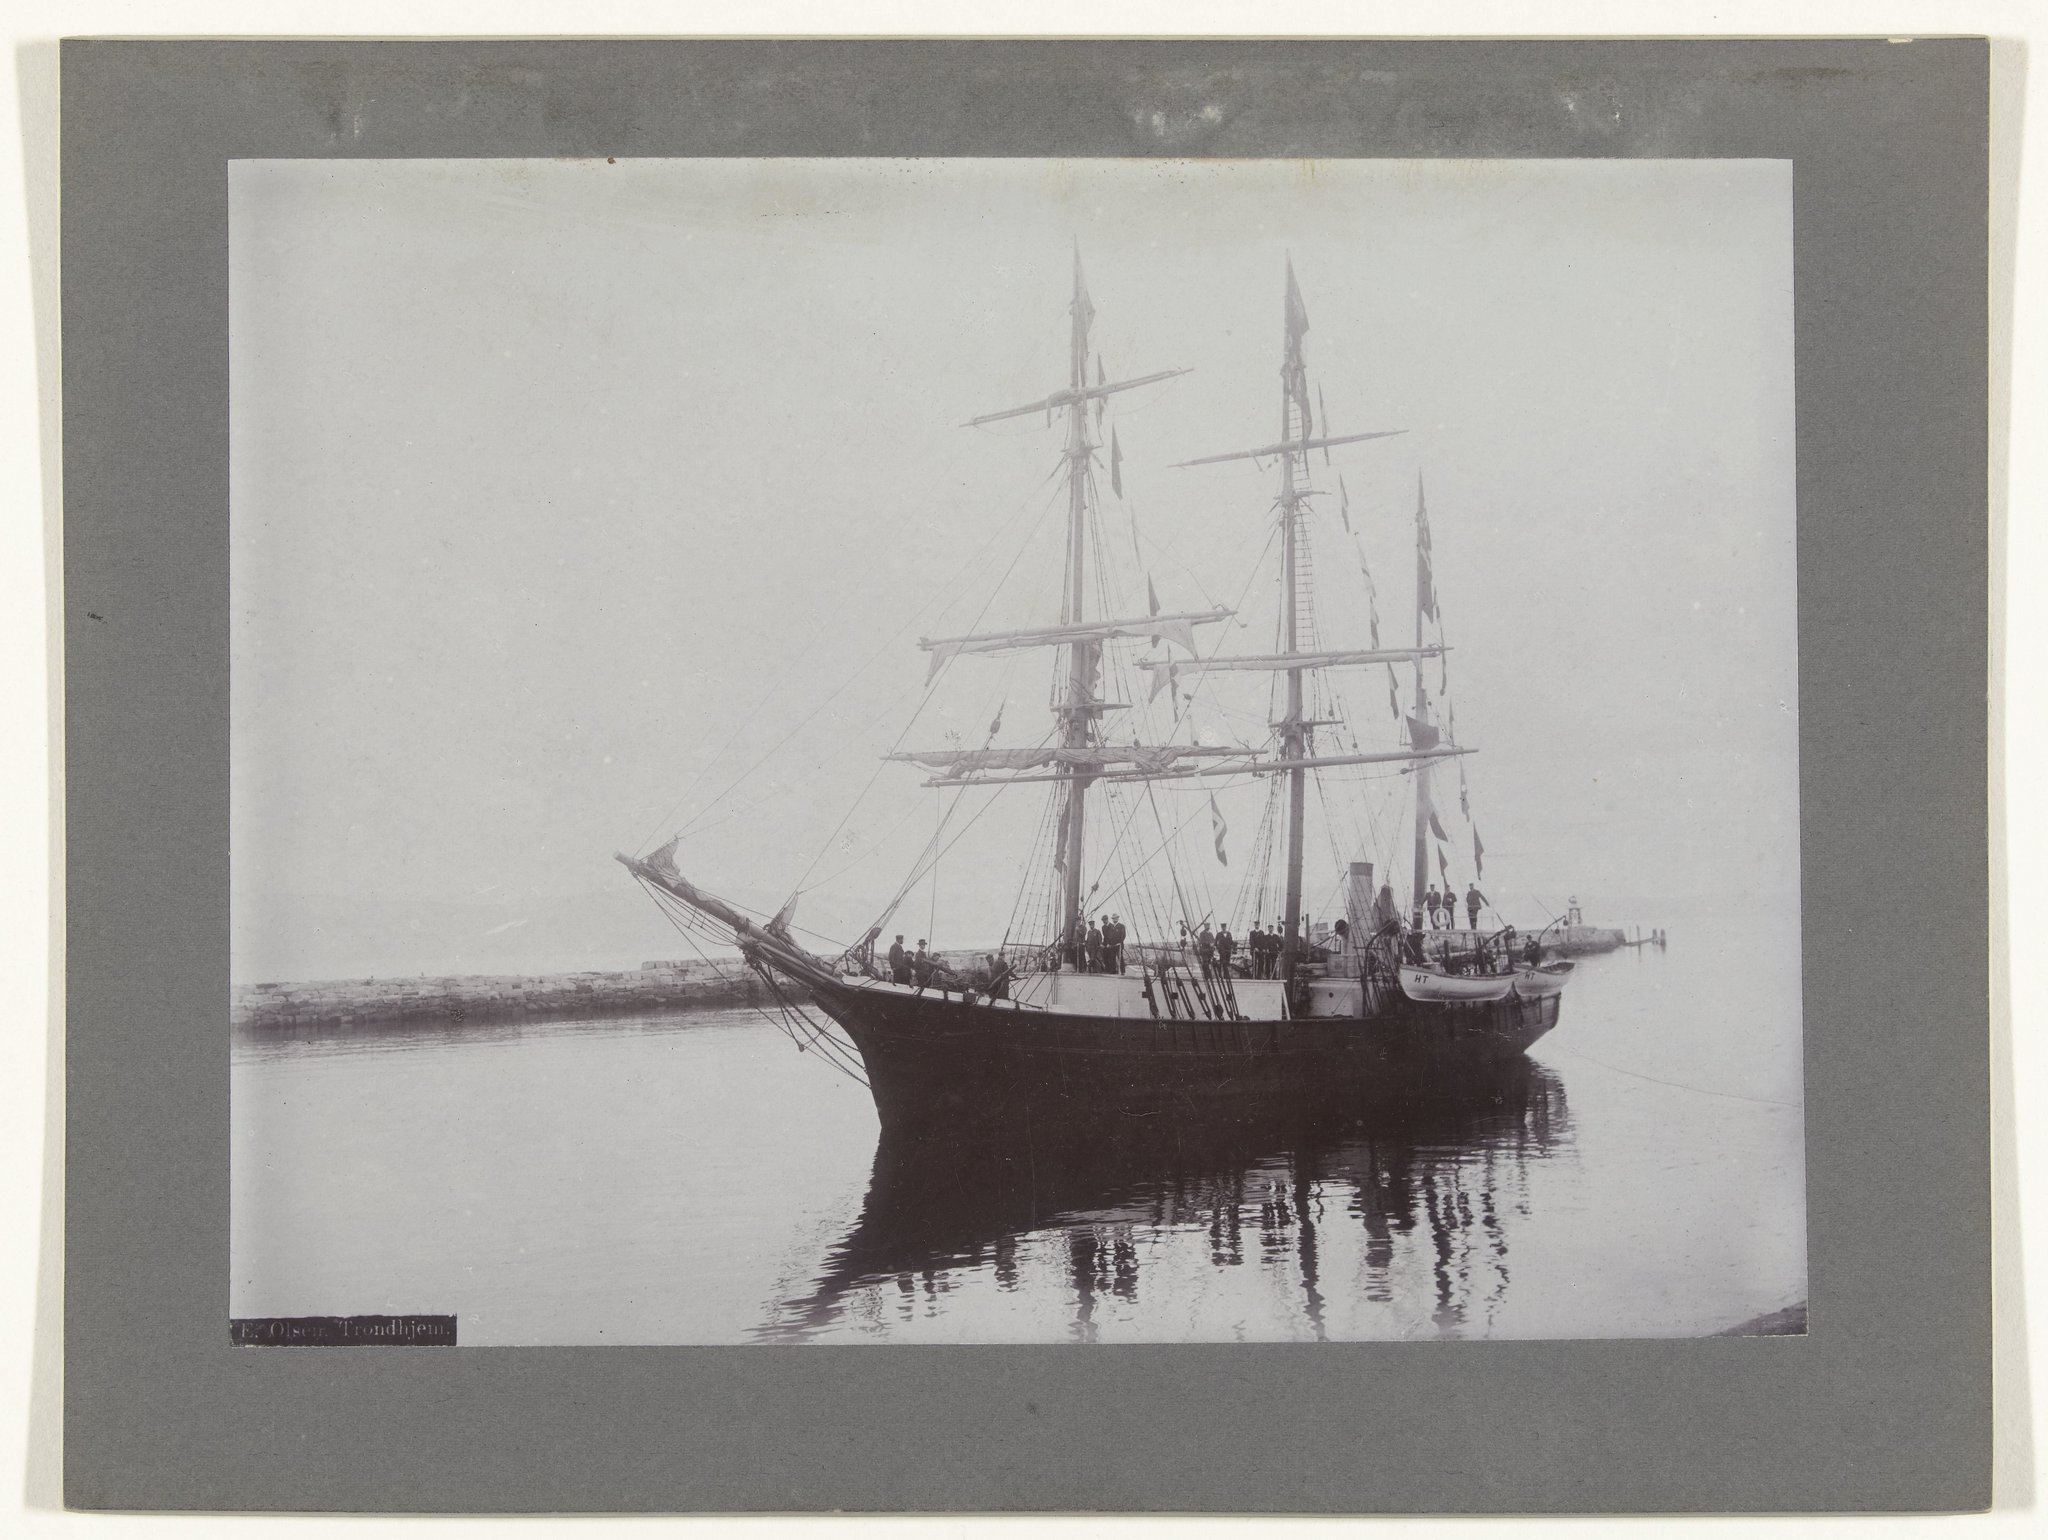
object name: photograph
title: Het zeilschip Hertha bij het verlaten van de haven van Trondheim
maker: erik olsen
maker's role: fotograaf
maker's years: 1835-1920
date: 1900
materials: cardboard, photographic support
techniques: gelatin silver print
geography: norway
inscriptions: annotation: ‘No 3067. / 1906.’, signature: ‘E. Olsen Trondhjem.’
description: Zie RP-F-2007-349-55-2 voor de naam van het schip